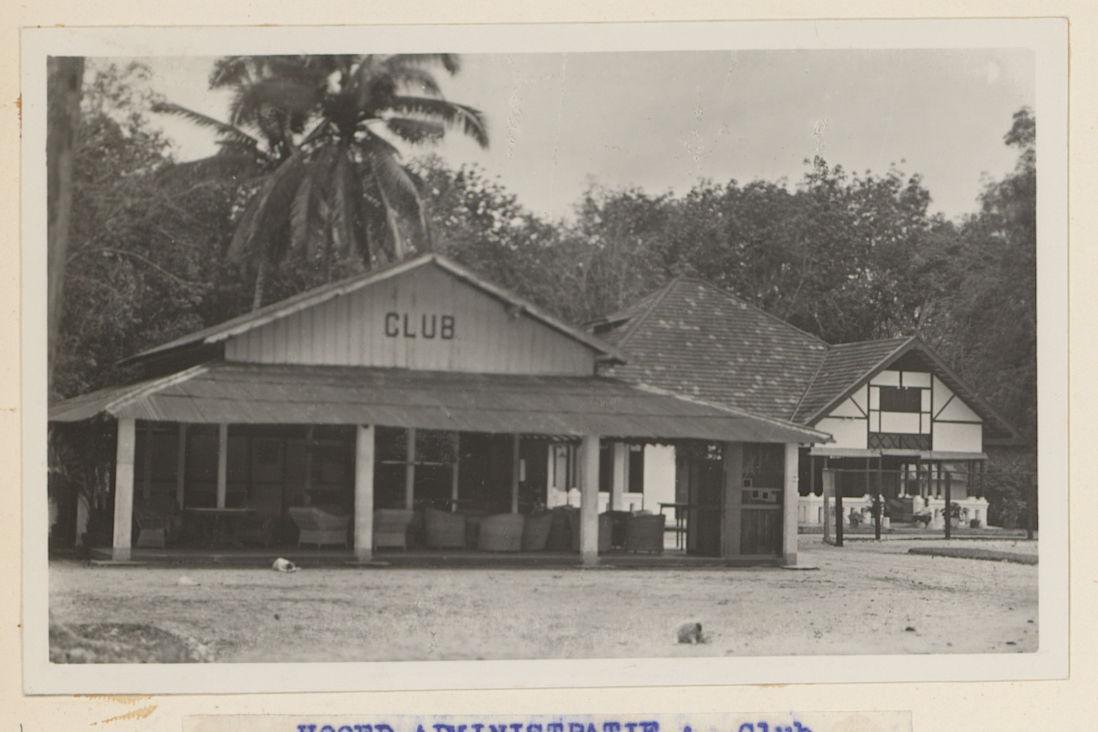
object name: photograph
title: Hoofd Administratie : Club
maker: Anonymous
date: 1933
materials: photographic support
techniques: gelatin silver print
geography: sumatra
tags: plantation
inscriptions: inscription: ‘Hoofd Administratie : Club (Reçu 2-10-33)’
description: Gebouw van de club van de Sucama bij de plantage Pernantian. Met etiket met onderschrift onder de foto. Onderdeel van het fotoalbum over de plantages Brussel en Pernantian van de Sumatra Caoutchouc Maatschappij op de Oostkust van Sumatra in de jaren 1910-1935.